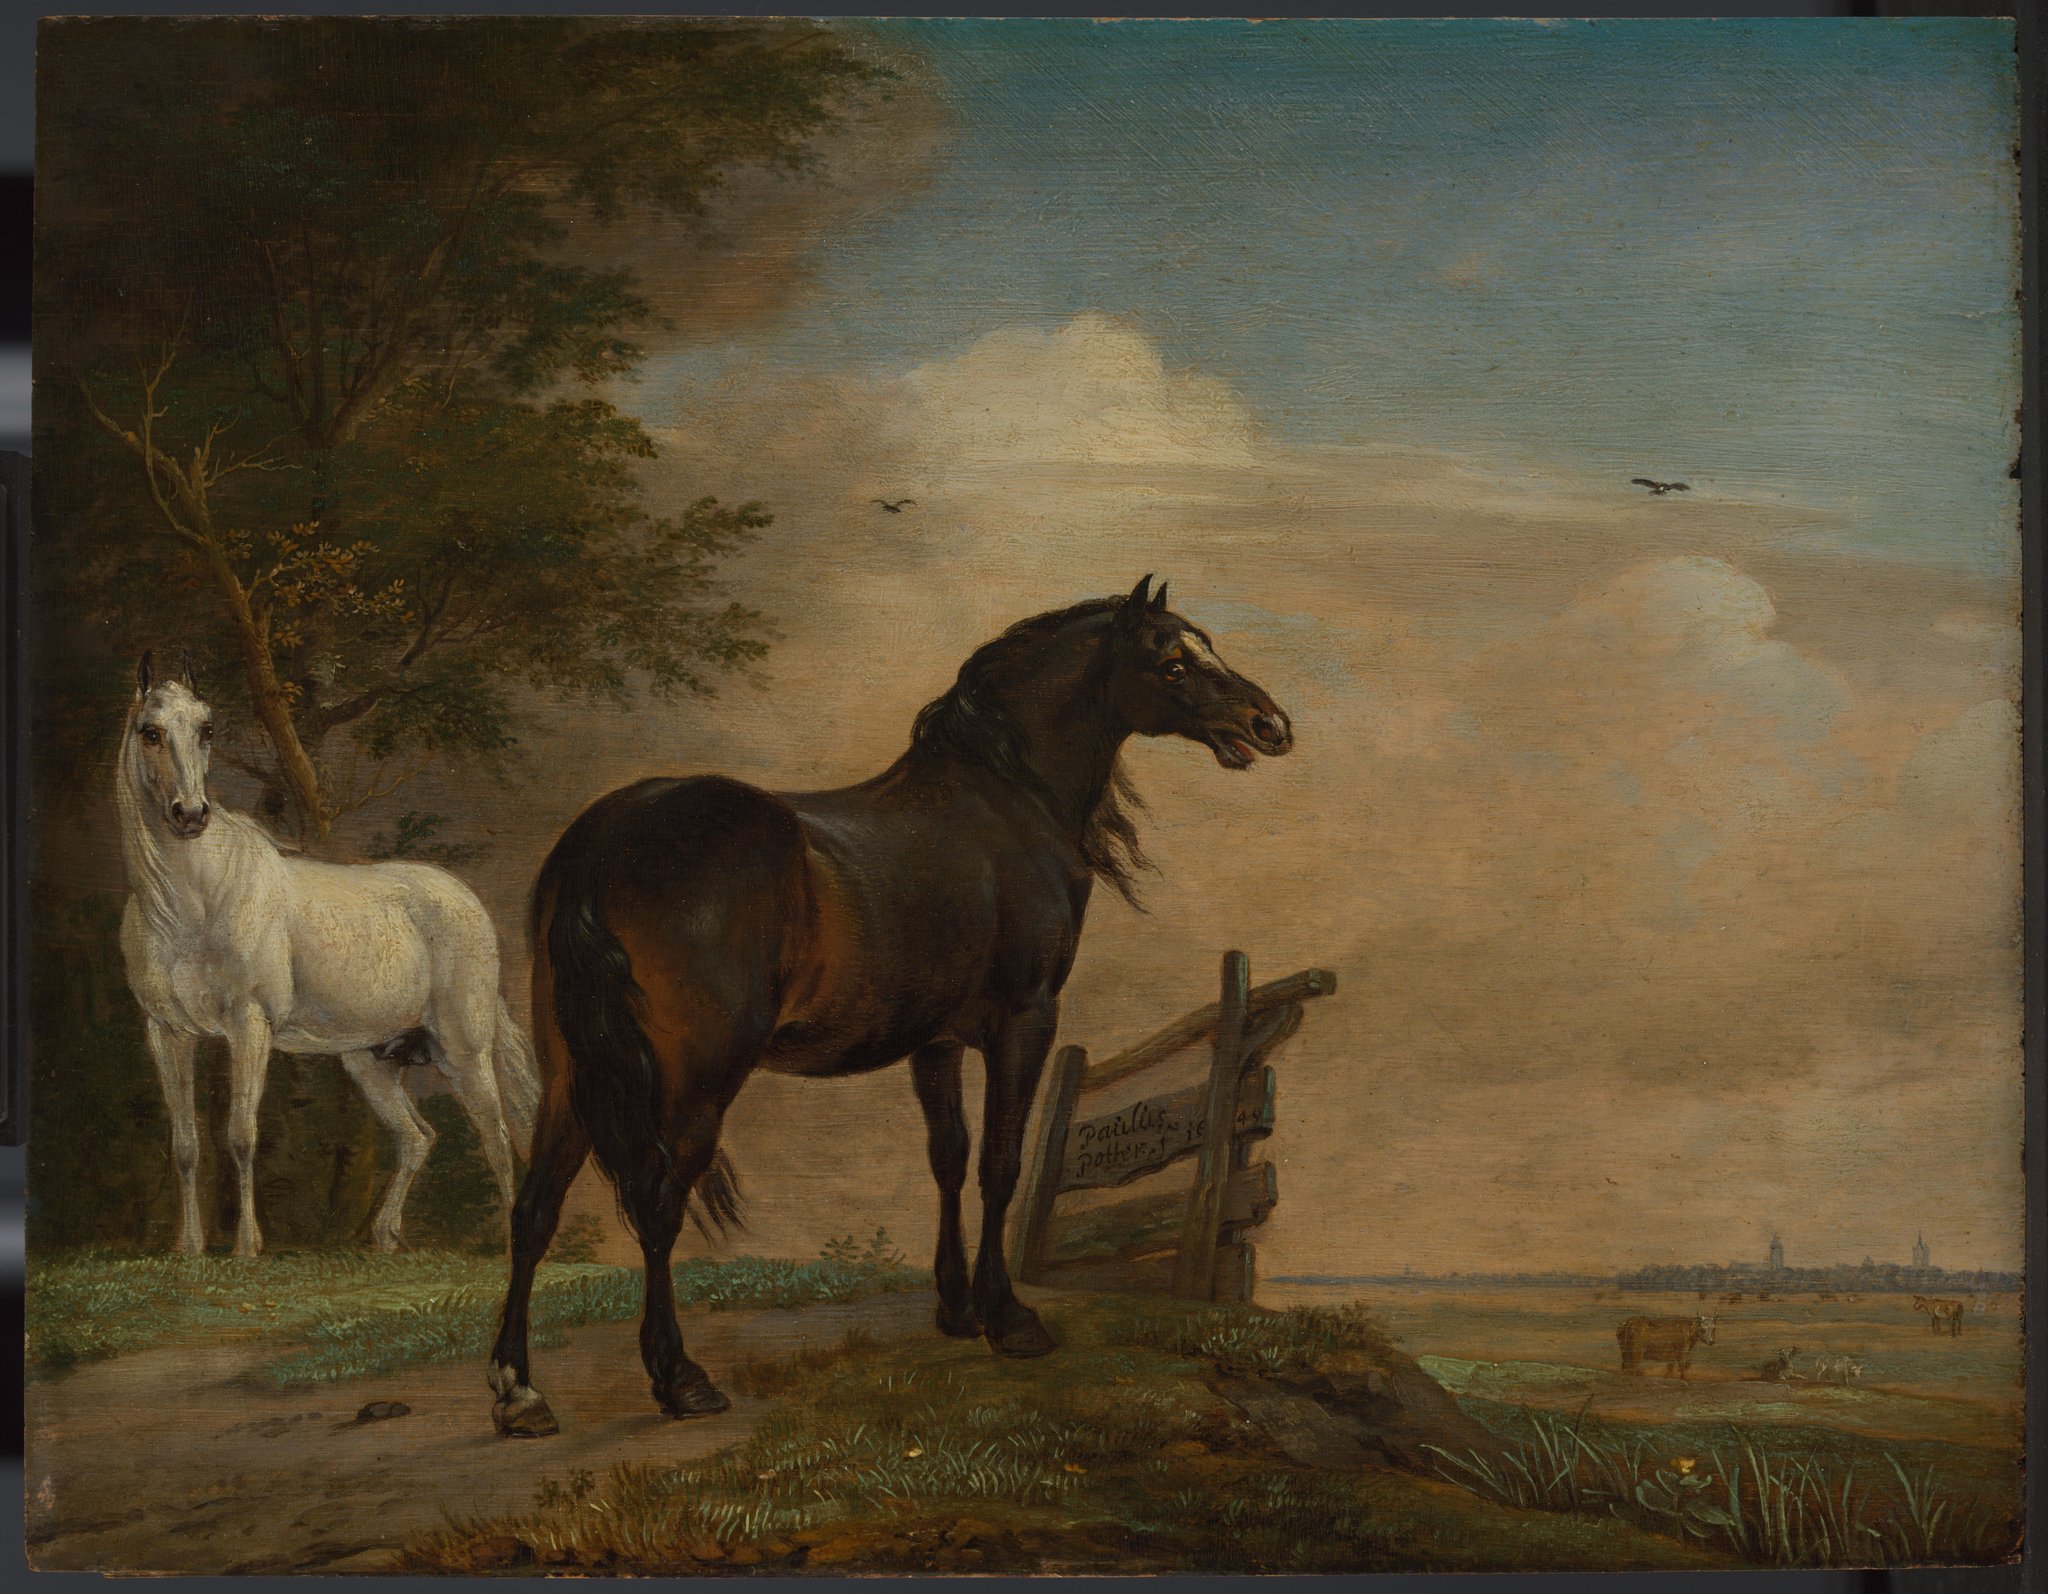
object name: painting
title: Two Horses in a Meadow near a Gate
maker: paulus potter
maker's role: draughtsman, painter, print maker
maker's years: 1625-1654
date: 1649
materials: oil, panel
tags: meadow, pasture, horse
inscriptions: signature and date: ‘Paulus Potter f 1649’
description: Two horses stand on a little rise before a sweeping meadow landscape with cattle. The town of Delft is visible in the distance. The animals’ fluttering tails and manes, and the low-lying clouds, signal that the weather is raw and windy. Potter enhances the liveliness of the depiction by placing the grey horse before a dark boscage and the chestnut horse before a light, cloud-filled sky.